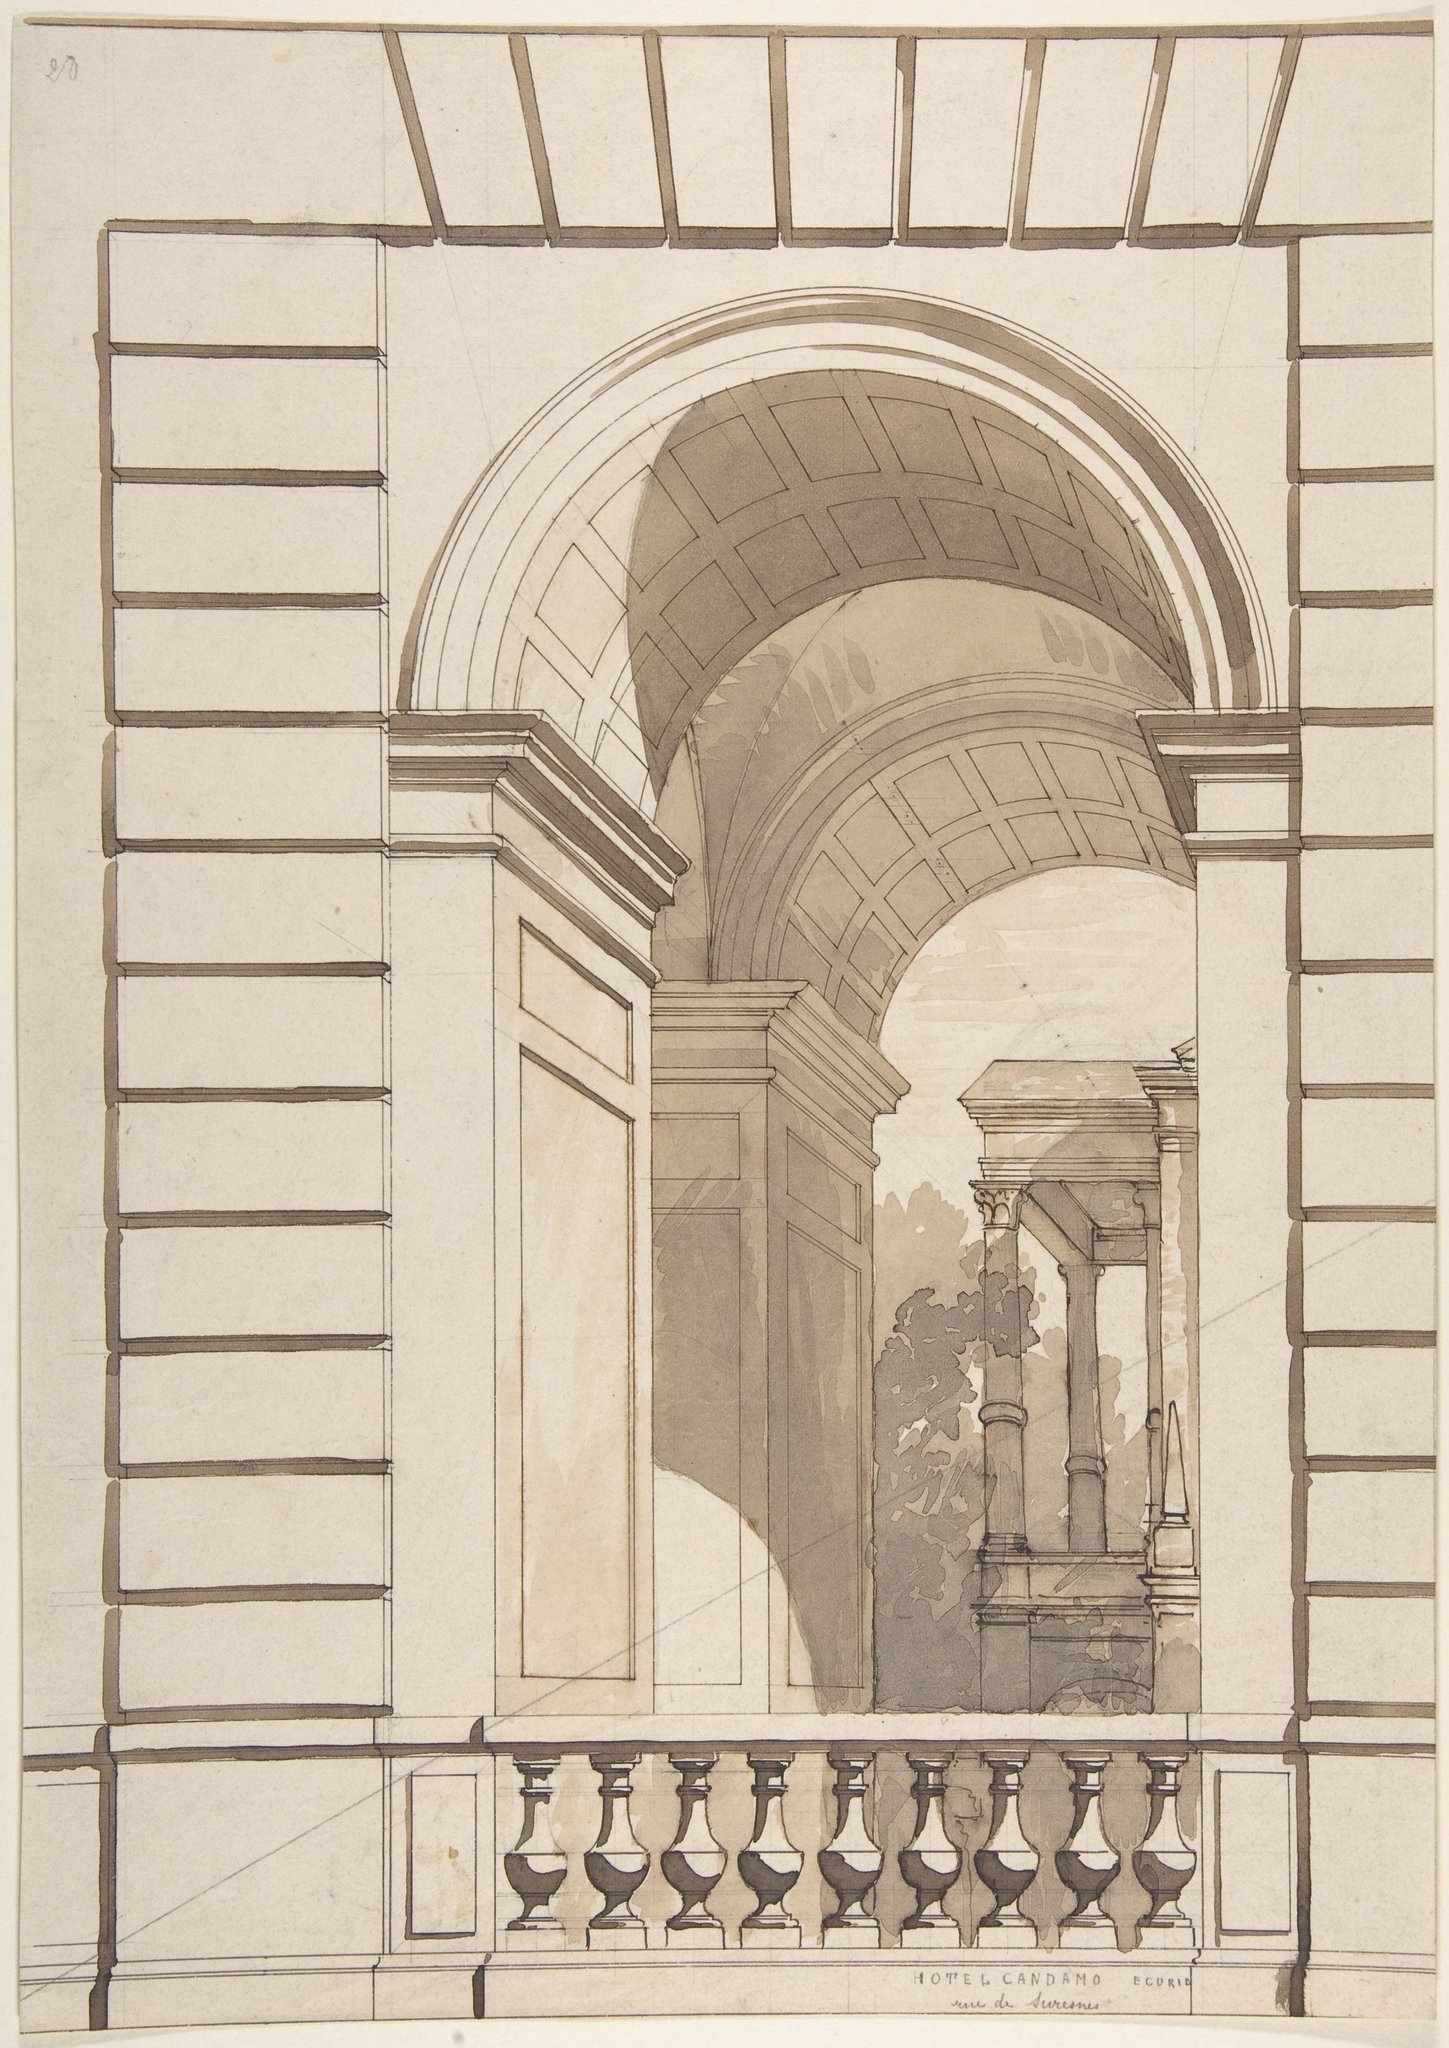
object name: drawing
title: Design for Stable Arches, Hôtel Candamo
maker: jules-edmond-charles lachaise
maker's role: artist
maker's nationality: french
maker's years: 1897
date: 1873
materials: ink, watercolor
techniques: pen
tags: arches,columns